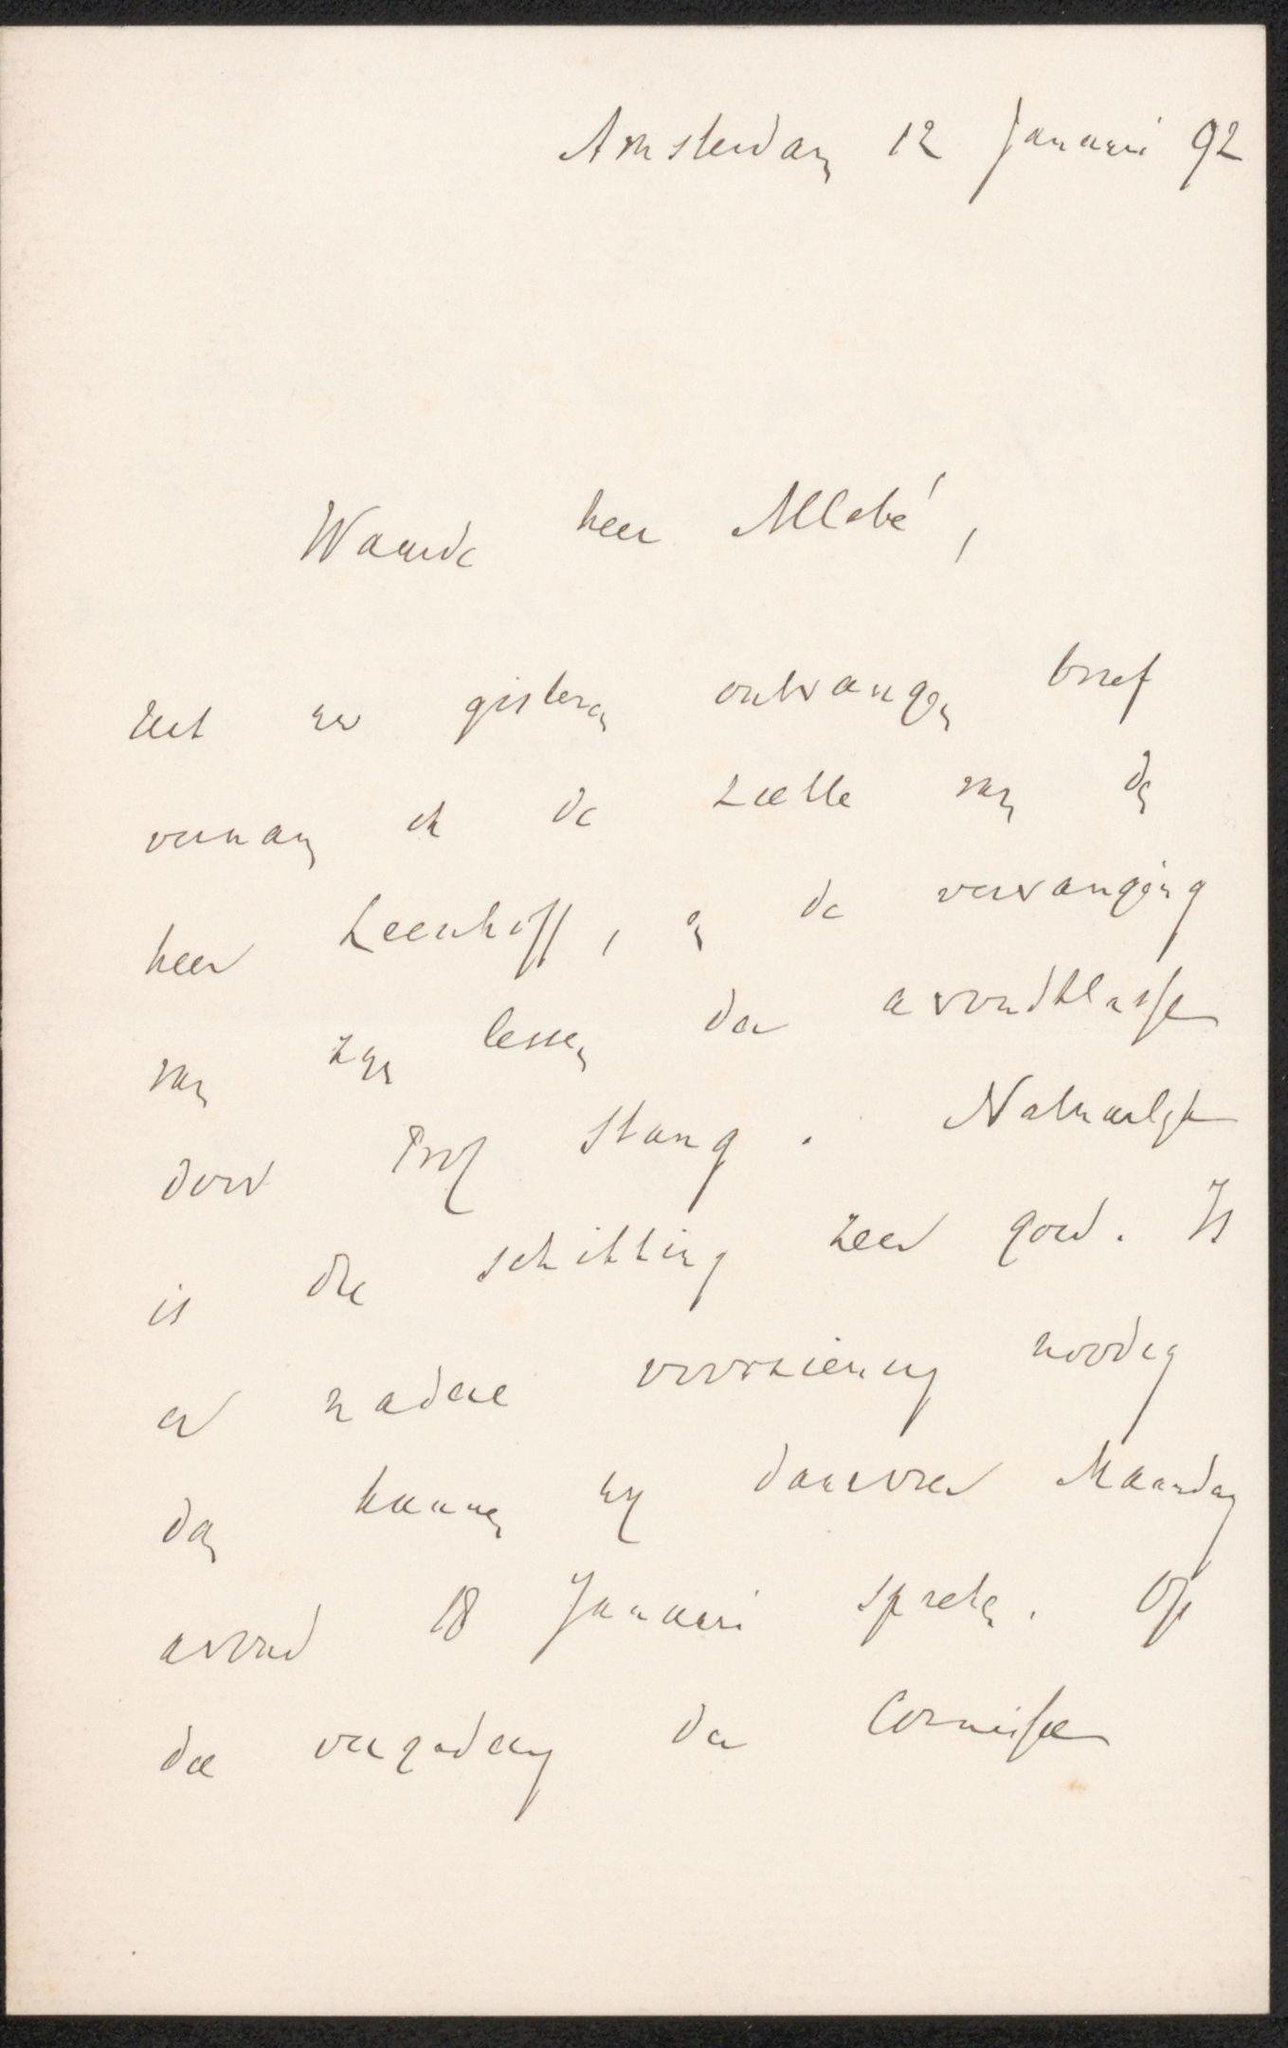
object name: letter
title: Brief aan August Allebé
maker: hendrick peter godfried quack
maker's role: econoom, geschiedschrijver, hoogleraar, jurist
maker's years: 1834-1917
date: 1892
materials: ink, paper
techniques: pen, writing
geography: amsterdam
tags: august allebé, painter, draughtsman, rudolf stang, print maker, ferdinand leenhoff, education, tuition of the artist (in general)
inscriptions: watermark